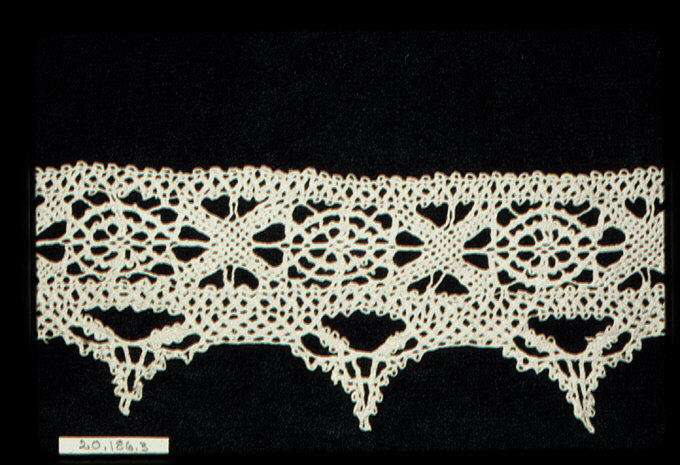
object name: edging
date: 1501-1600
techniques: lace